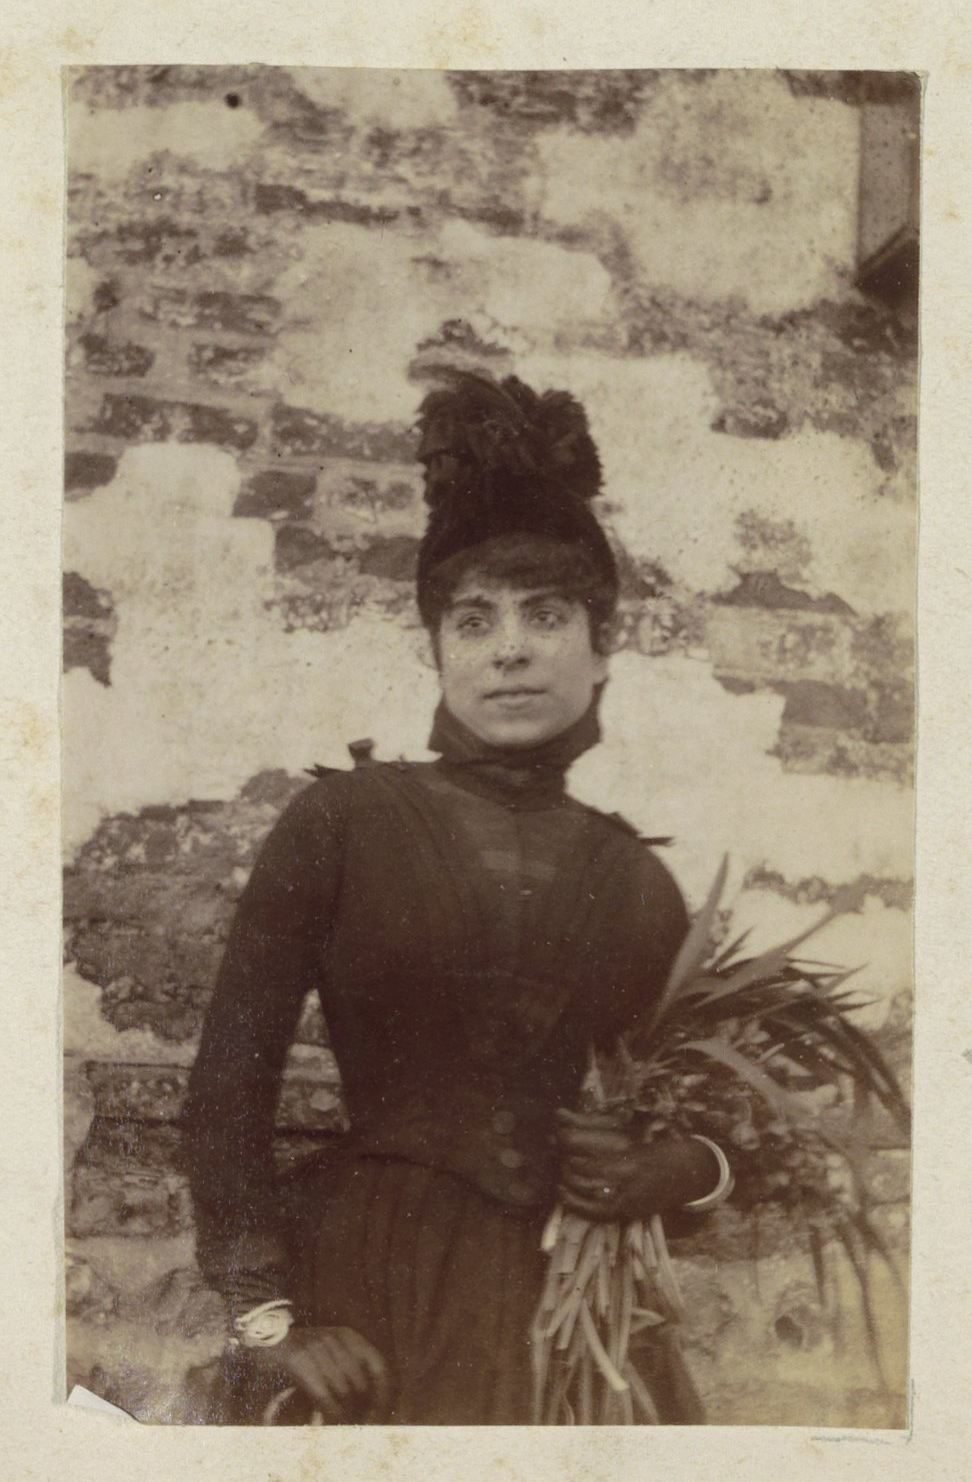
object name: photograph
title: Portret van een jonge vrouw met een boeket in de hand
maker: Anonymous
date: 1808-1886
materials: photographic support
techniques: albumen print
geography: france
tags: adult woman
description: Onderdeel van Album van een Franse amateurfotograaf met opnames van familie, militairen, industrie, landschappen en bezienswaardigheden in Frankrijk.